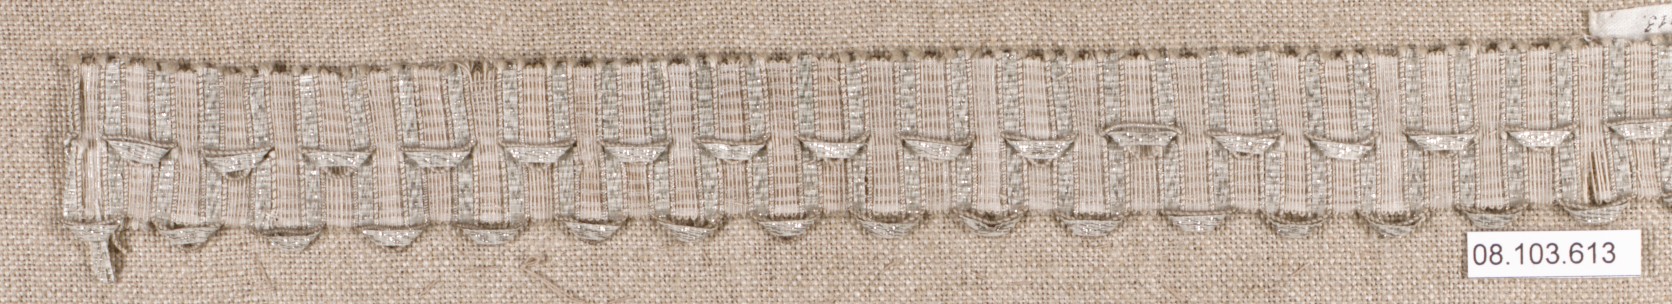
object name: galloon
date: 1701-1800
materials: metal thread, silk